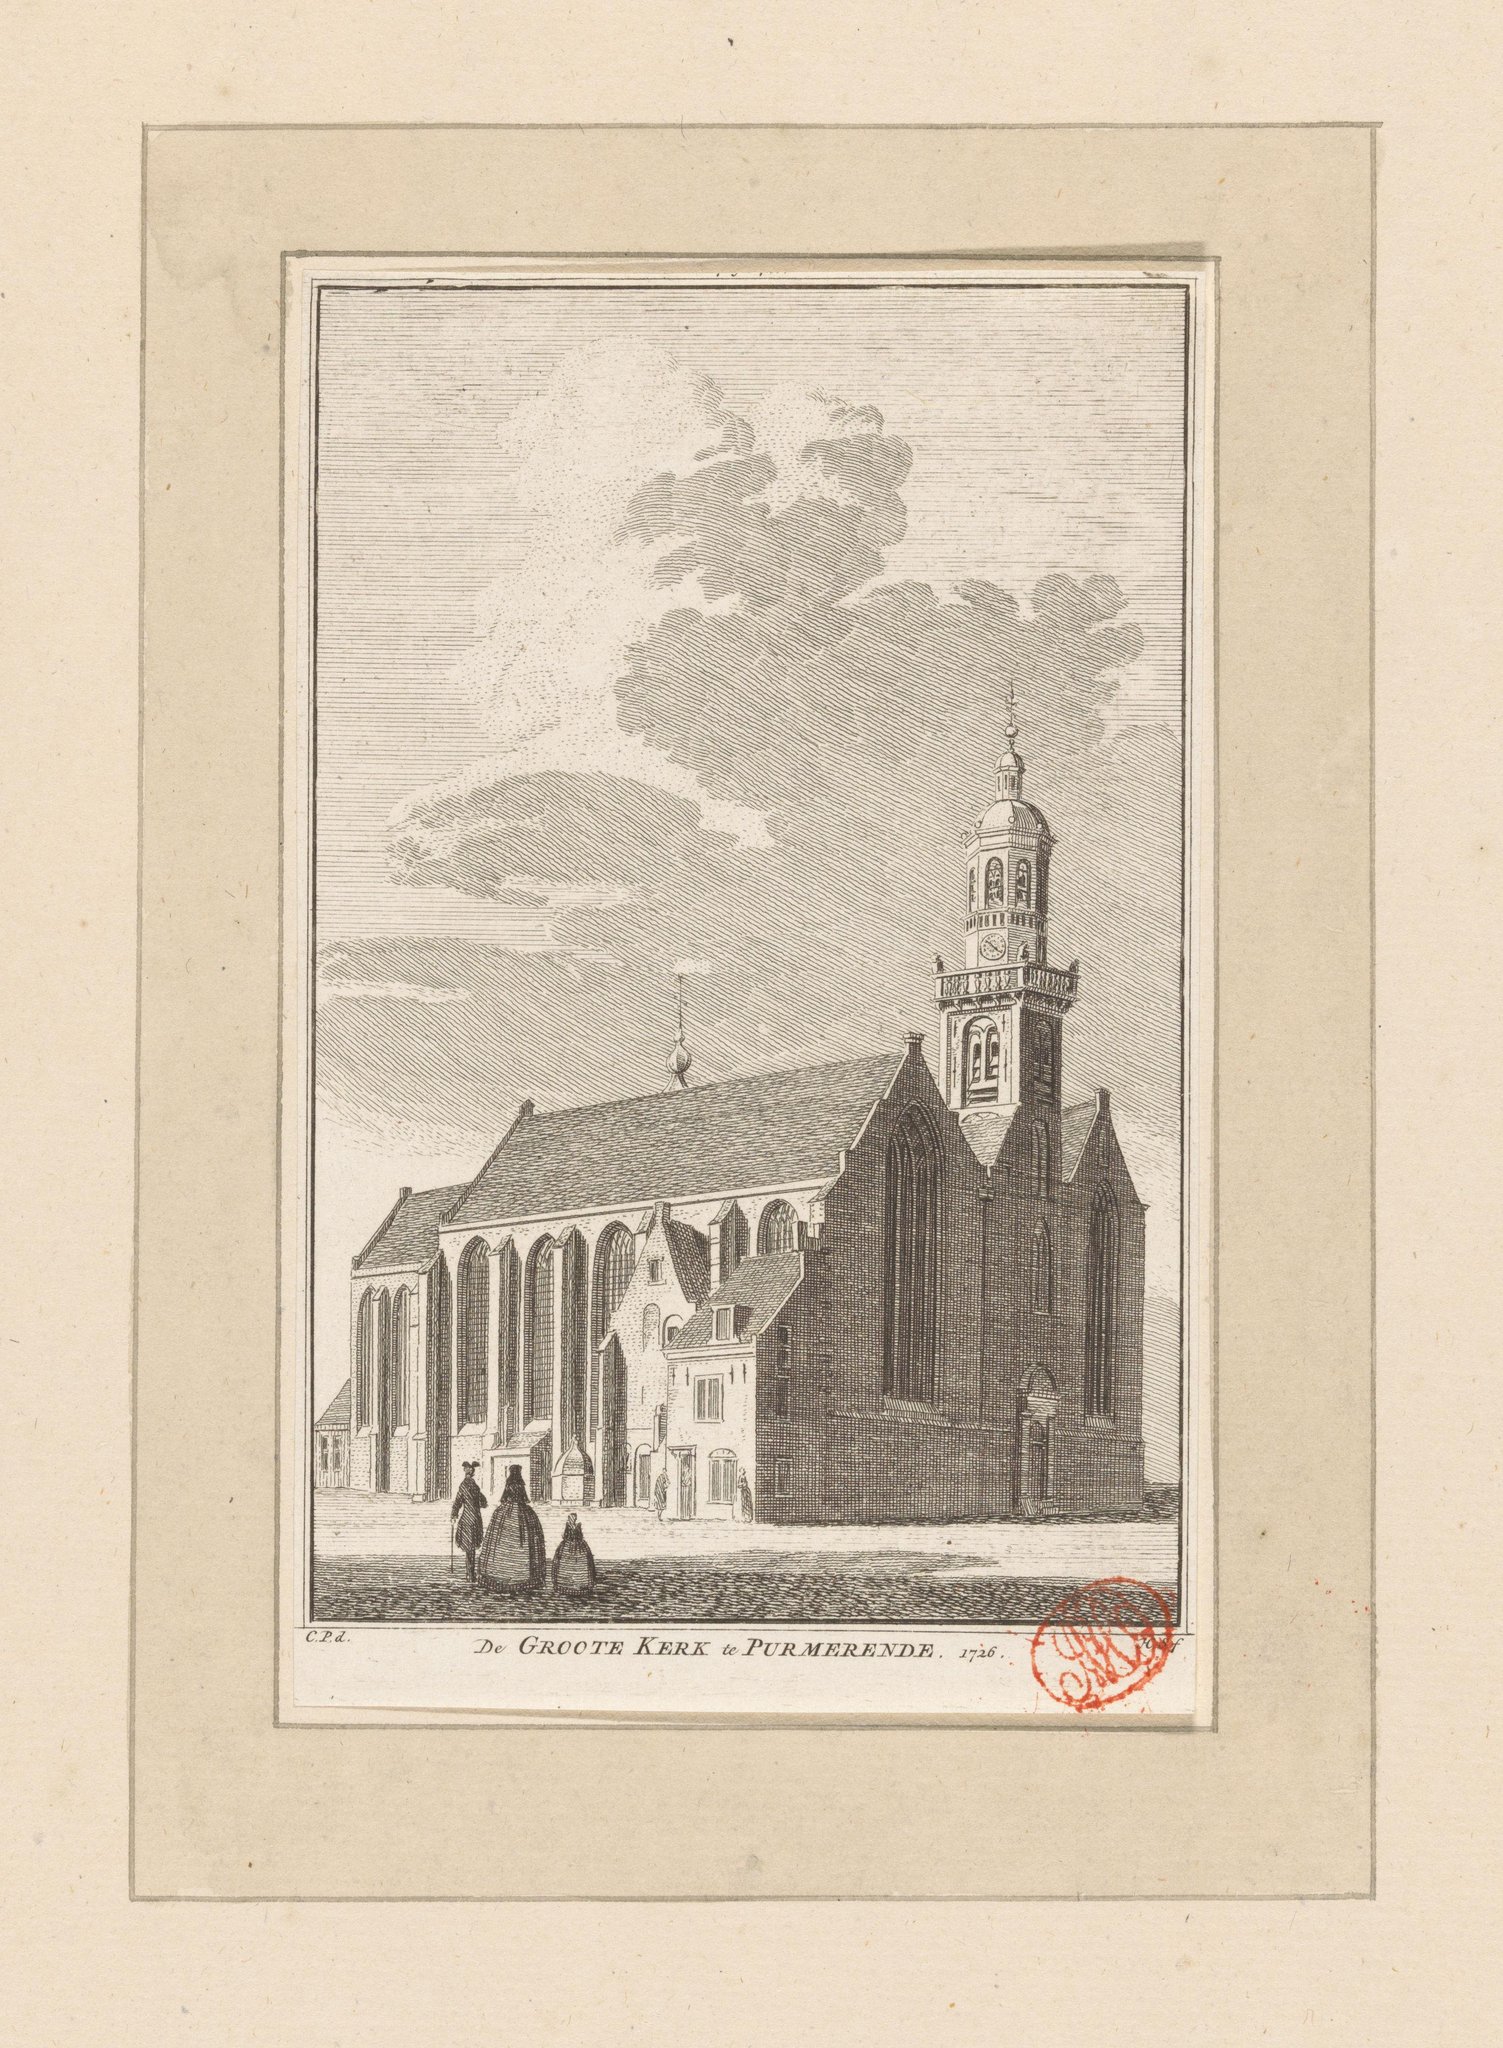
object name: print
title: De Groote Kerk te Purmerende. 1726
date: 1757-1792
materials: paper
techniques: engraving, etching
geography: haarlem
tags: church (exterior)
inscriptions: collector's mark: Lugt 195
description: Prent ook gebruikt in: Het verheerlykt Nederland of kabinet van hedendaagsche gezigten van steden, dorpen (…). 9 delen. Amsterdam: Isaak Tirion en weduwe Isaak Tirion, 1745-1774, dl. 6 (1757), ill. 425-426. Of in: Nederlandsche tafereelen; of eene keurige verzameling van negen honderd fraaije gezigten van steden, dorpen, sloten, oudheden (….). 9 delen. Amsterdam: Jan de Groot, 1792, dl. 6, ill. 425-426. Uit welke druk het huidige exemplaar precies komt is niet na te gaan.